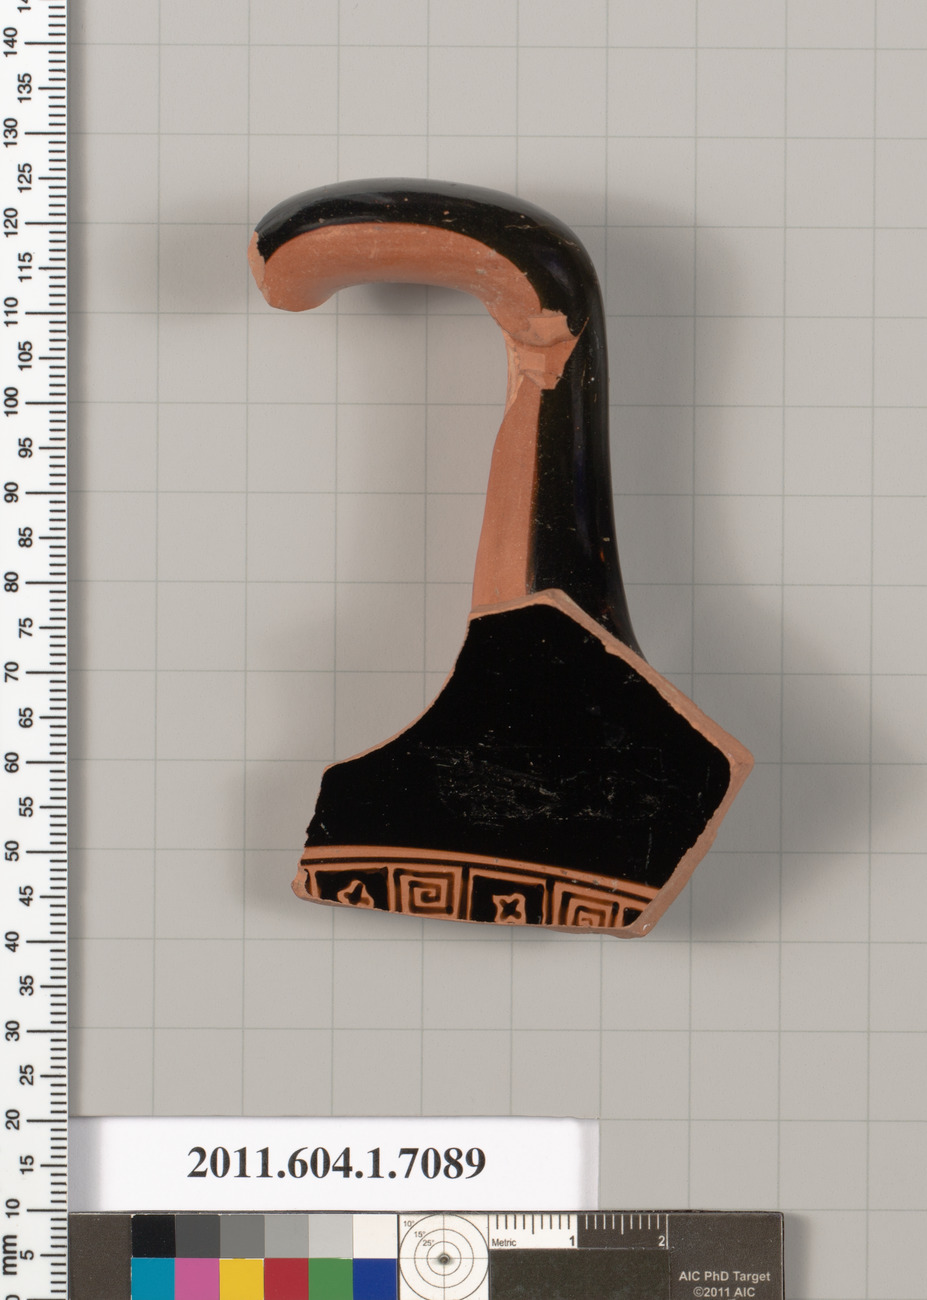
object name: kylix fragment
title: Terracotta fragment of a kylix (drinking cup)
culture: greek, attic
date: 500-480 BCE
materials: terracotta